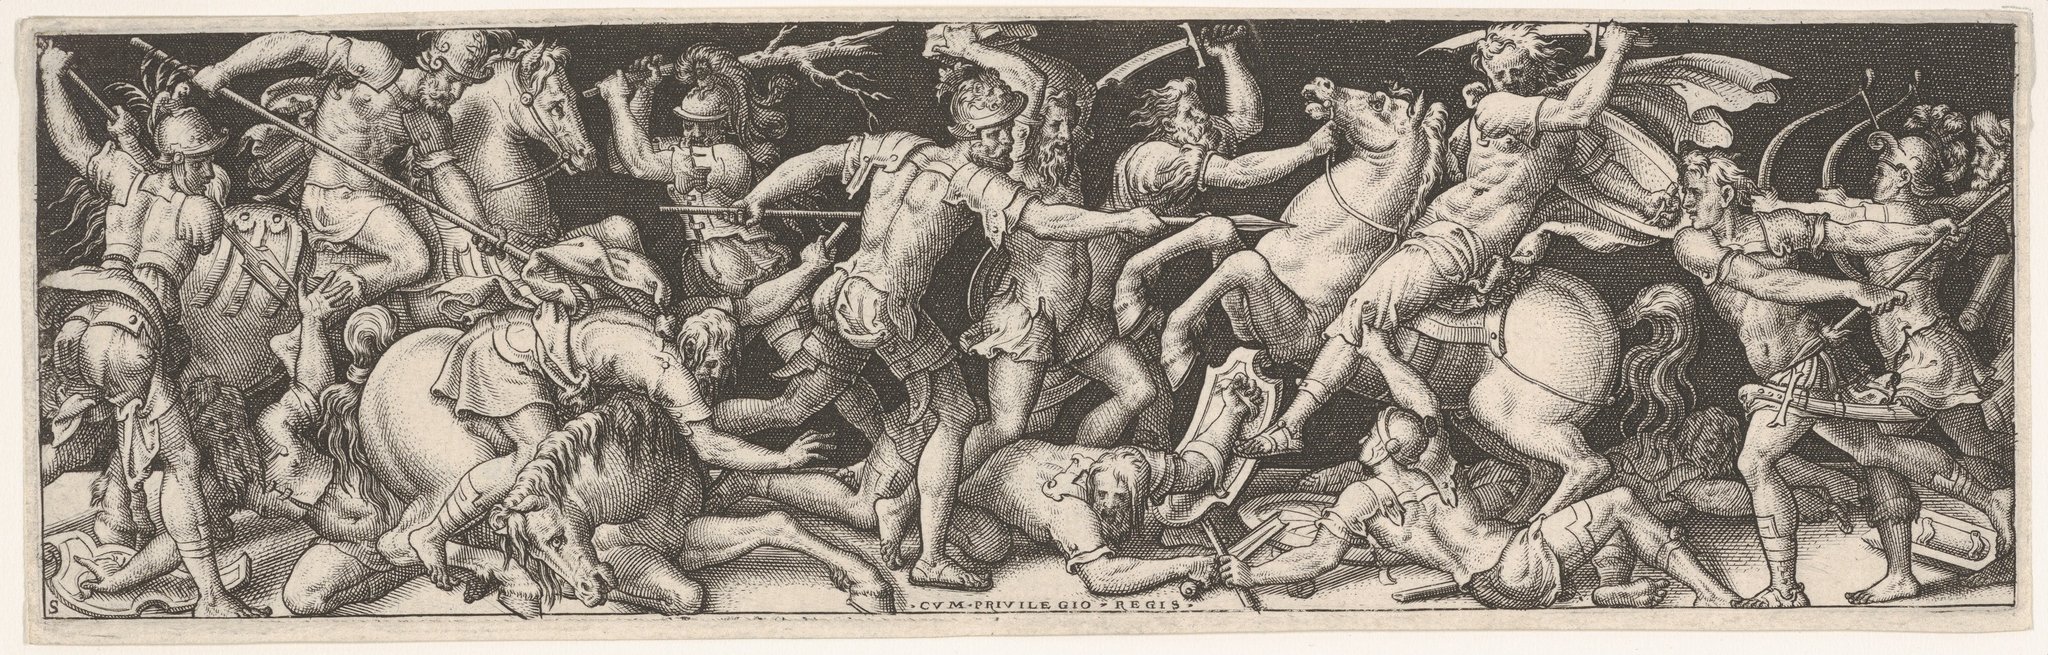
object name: print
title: Plate from "Combats et Triomphes"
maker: etienne delaune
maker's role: artist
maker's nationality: french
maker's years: 1518-1583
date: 1540-1583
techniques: engraving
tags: battles,weapons,men,horses